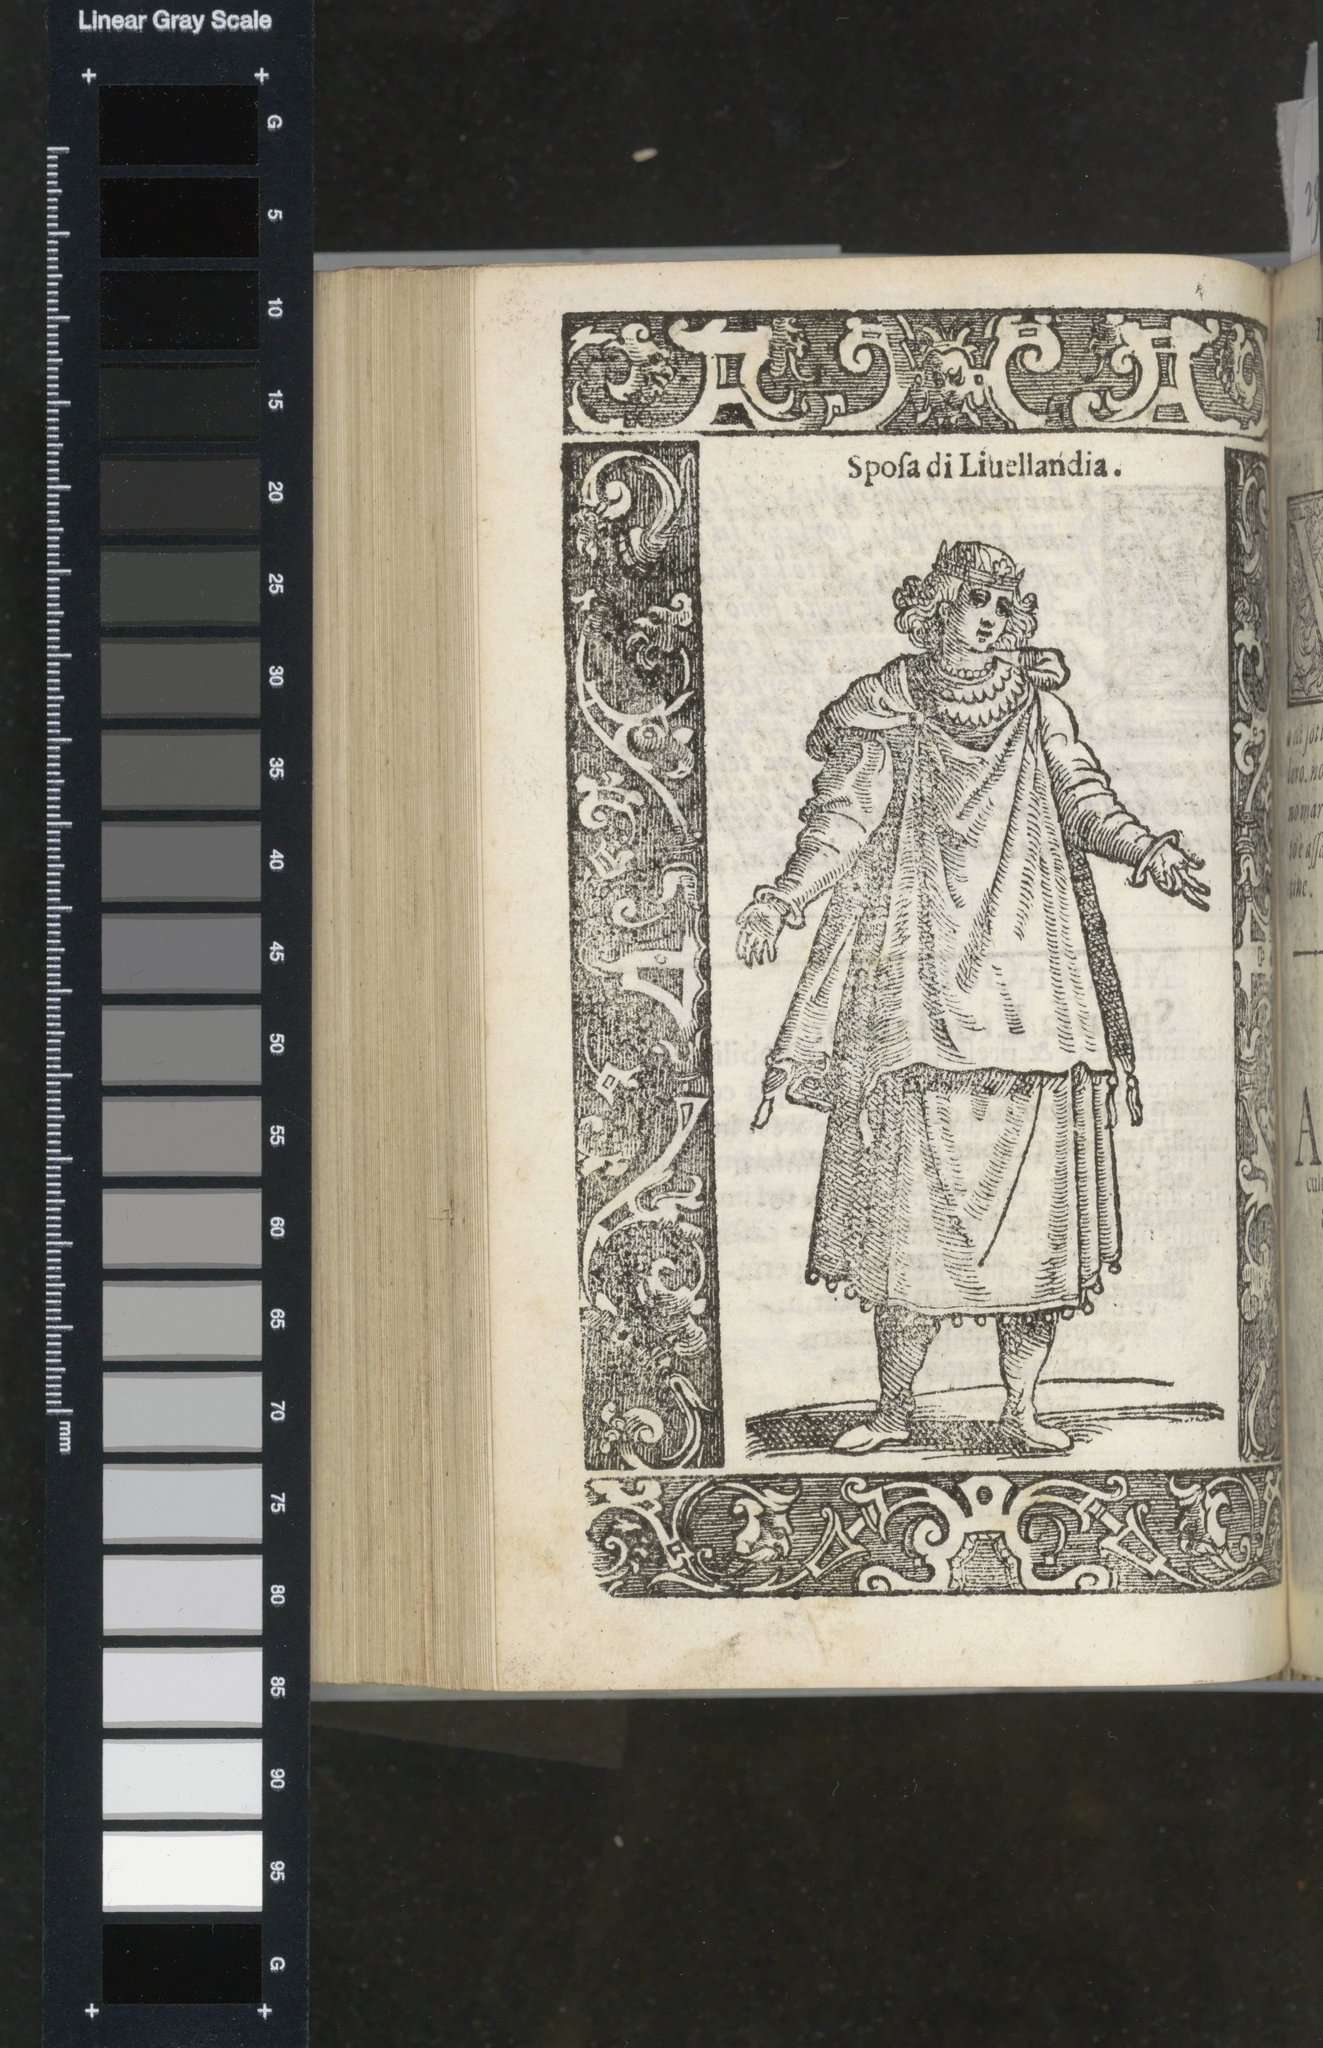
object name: costume print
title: Sposa di Livellandia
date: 1598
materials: paper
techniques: woodcut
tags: fashion plates